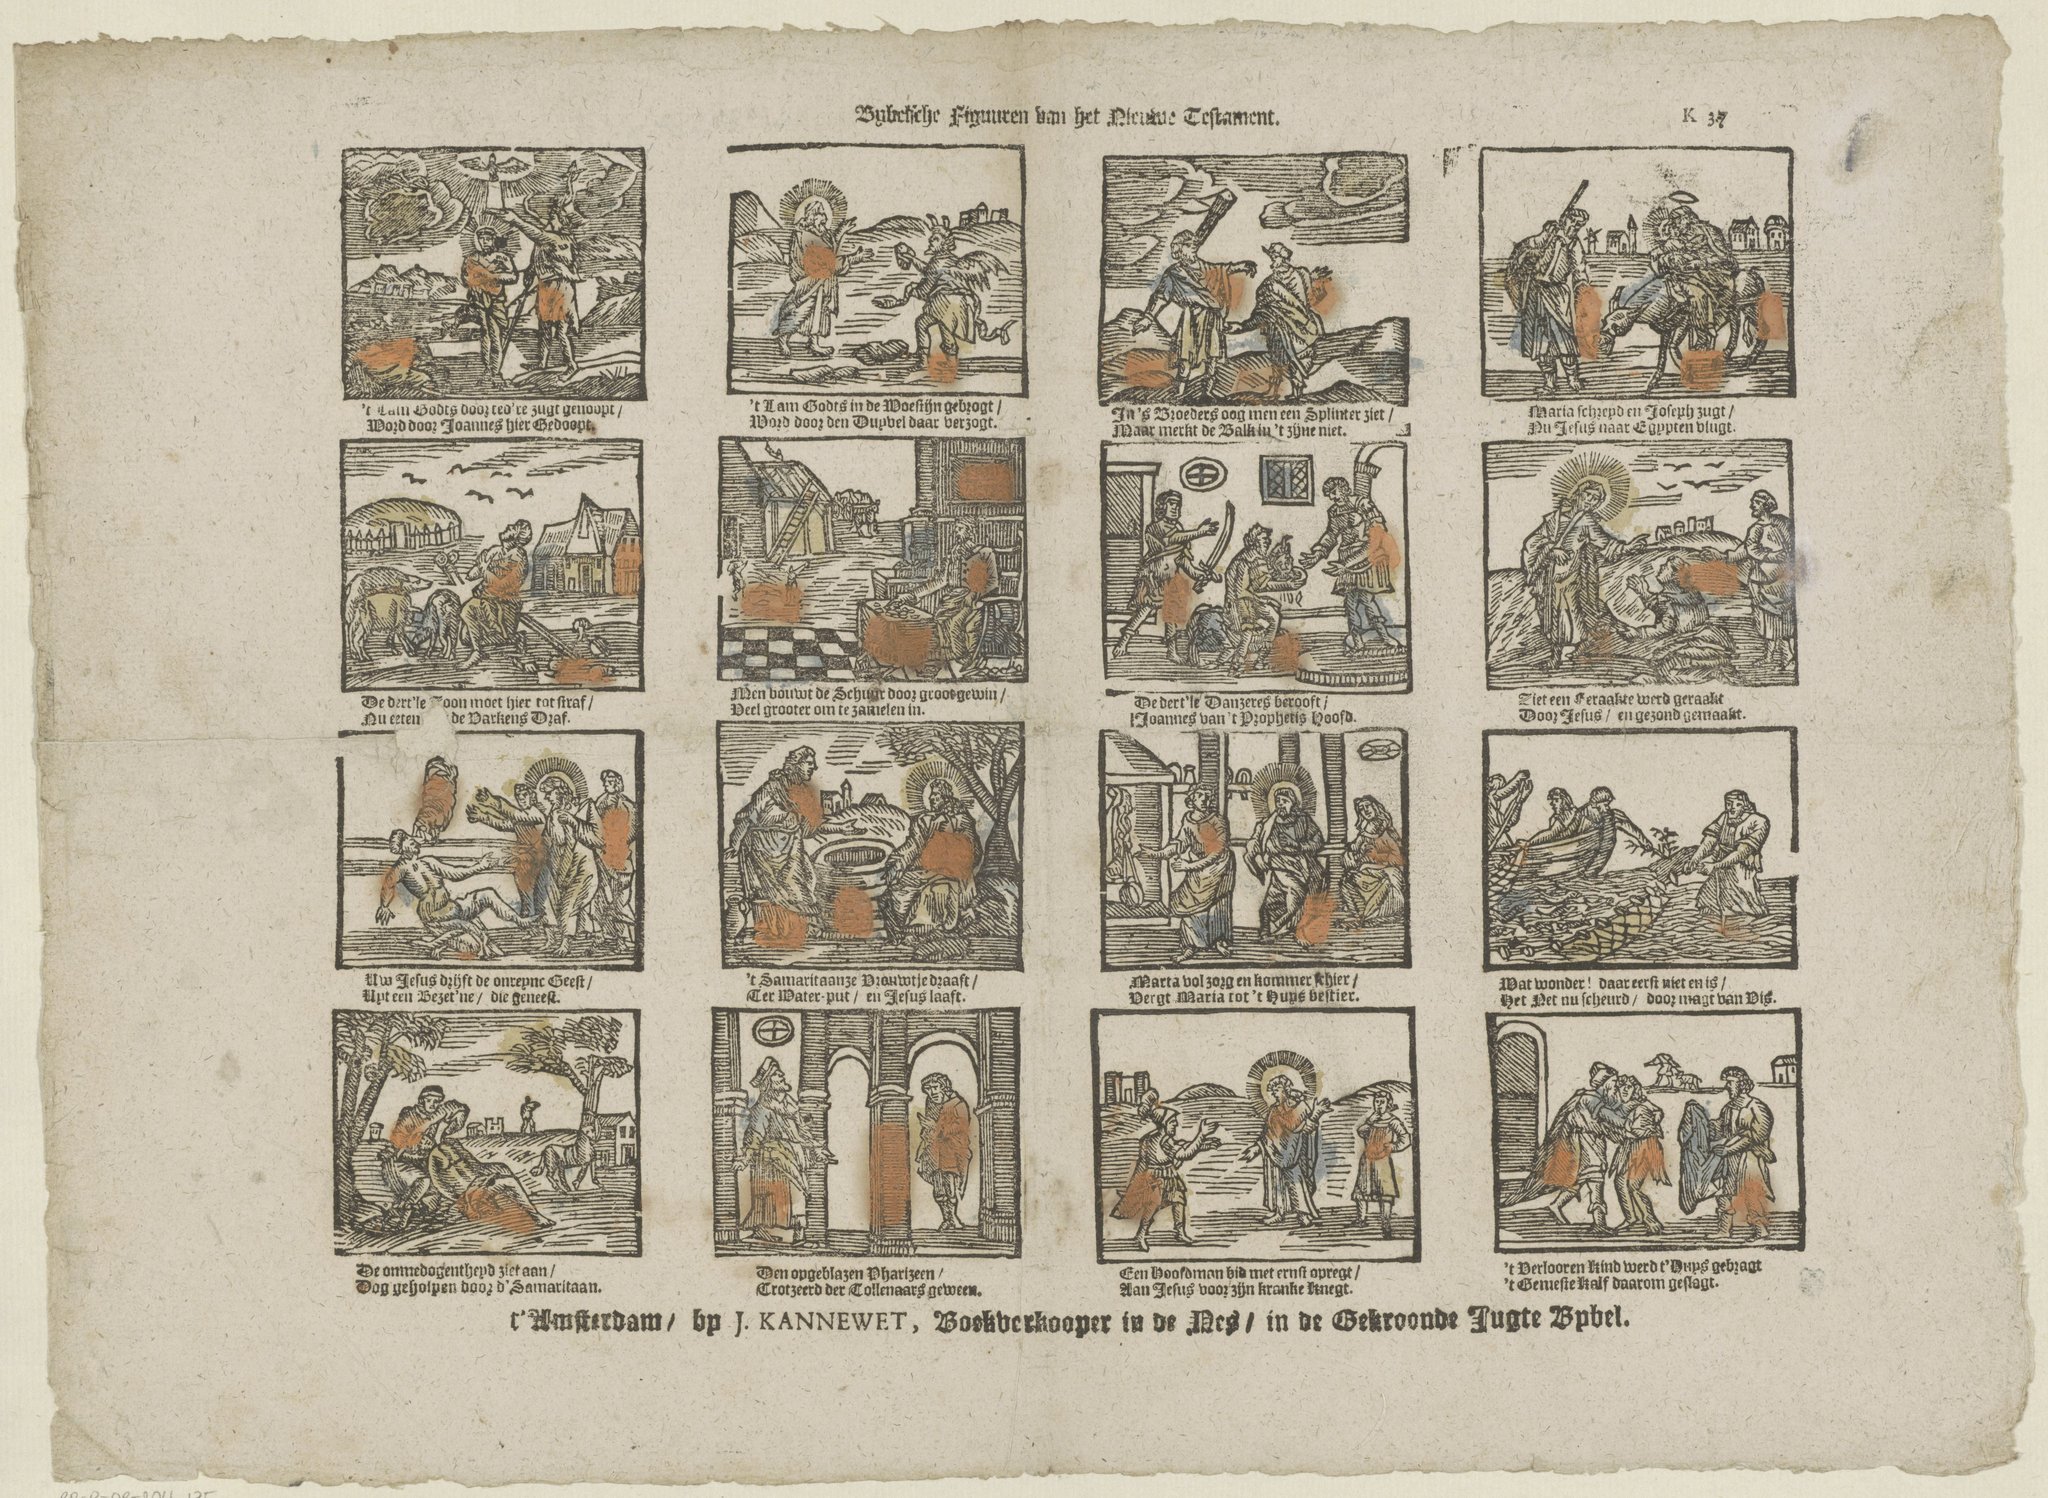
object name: print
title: Bybelsche figuuren van het Nieuwe Testament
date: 1725-1780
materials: paper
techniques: colour, letterpress printing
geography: netherlands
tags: the flight into egypt: mary, joseph, the child (and sometimes others) on their way; mary usually riding on an ass, the miraculous draught of fishes (before the resurrection) on the lake of gennesaret (sea of galilee); james and john helping to bring in the nets (luke 5:1-11), new testament, the parable of the prodigal son (luke 15:11-32)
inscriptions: collector's mark: Lugt 2760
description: Blad met 16 voorstellingen van verhalen uit het Nieuwe Testament, zoals de vlucht naar Egypte, Christus en de Samaritaanse vrouw bij de put en de wonderbare visvangst. Onder elke voorstelling een tweeregelig vers. Genummerd rechtsboven: K 37.